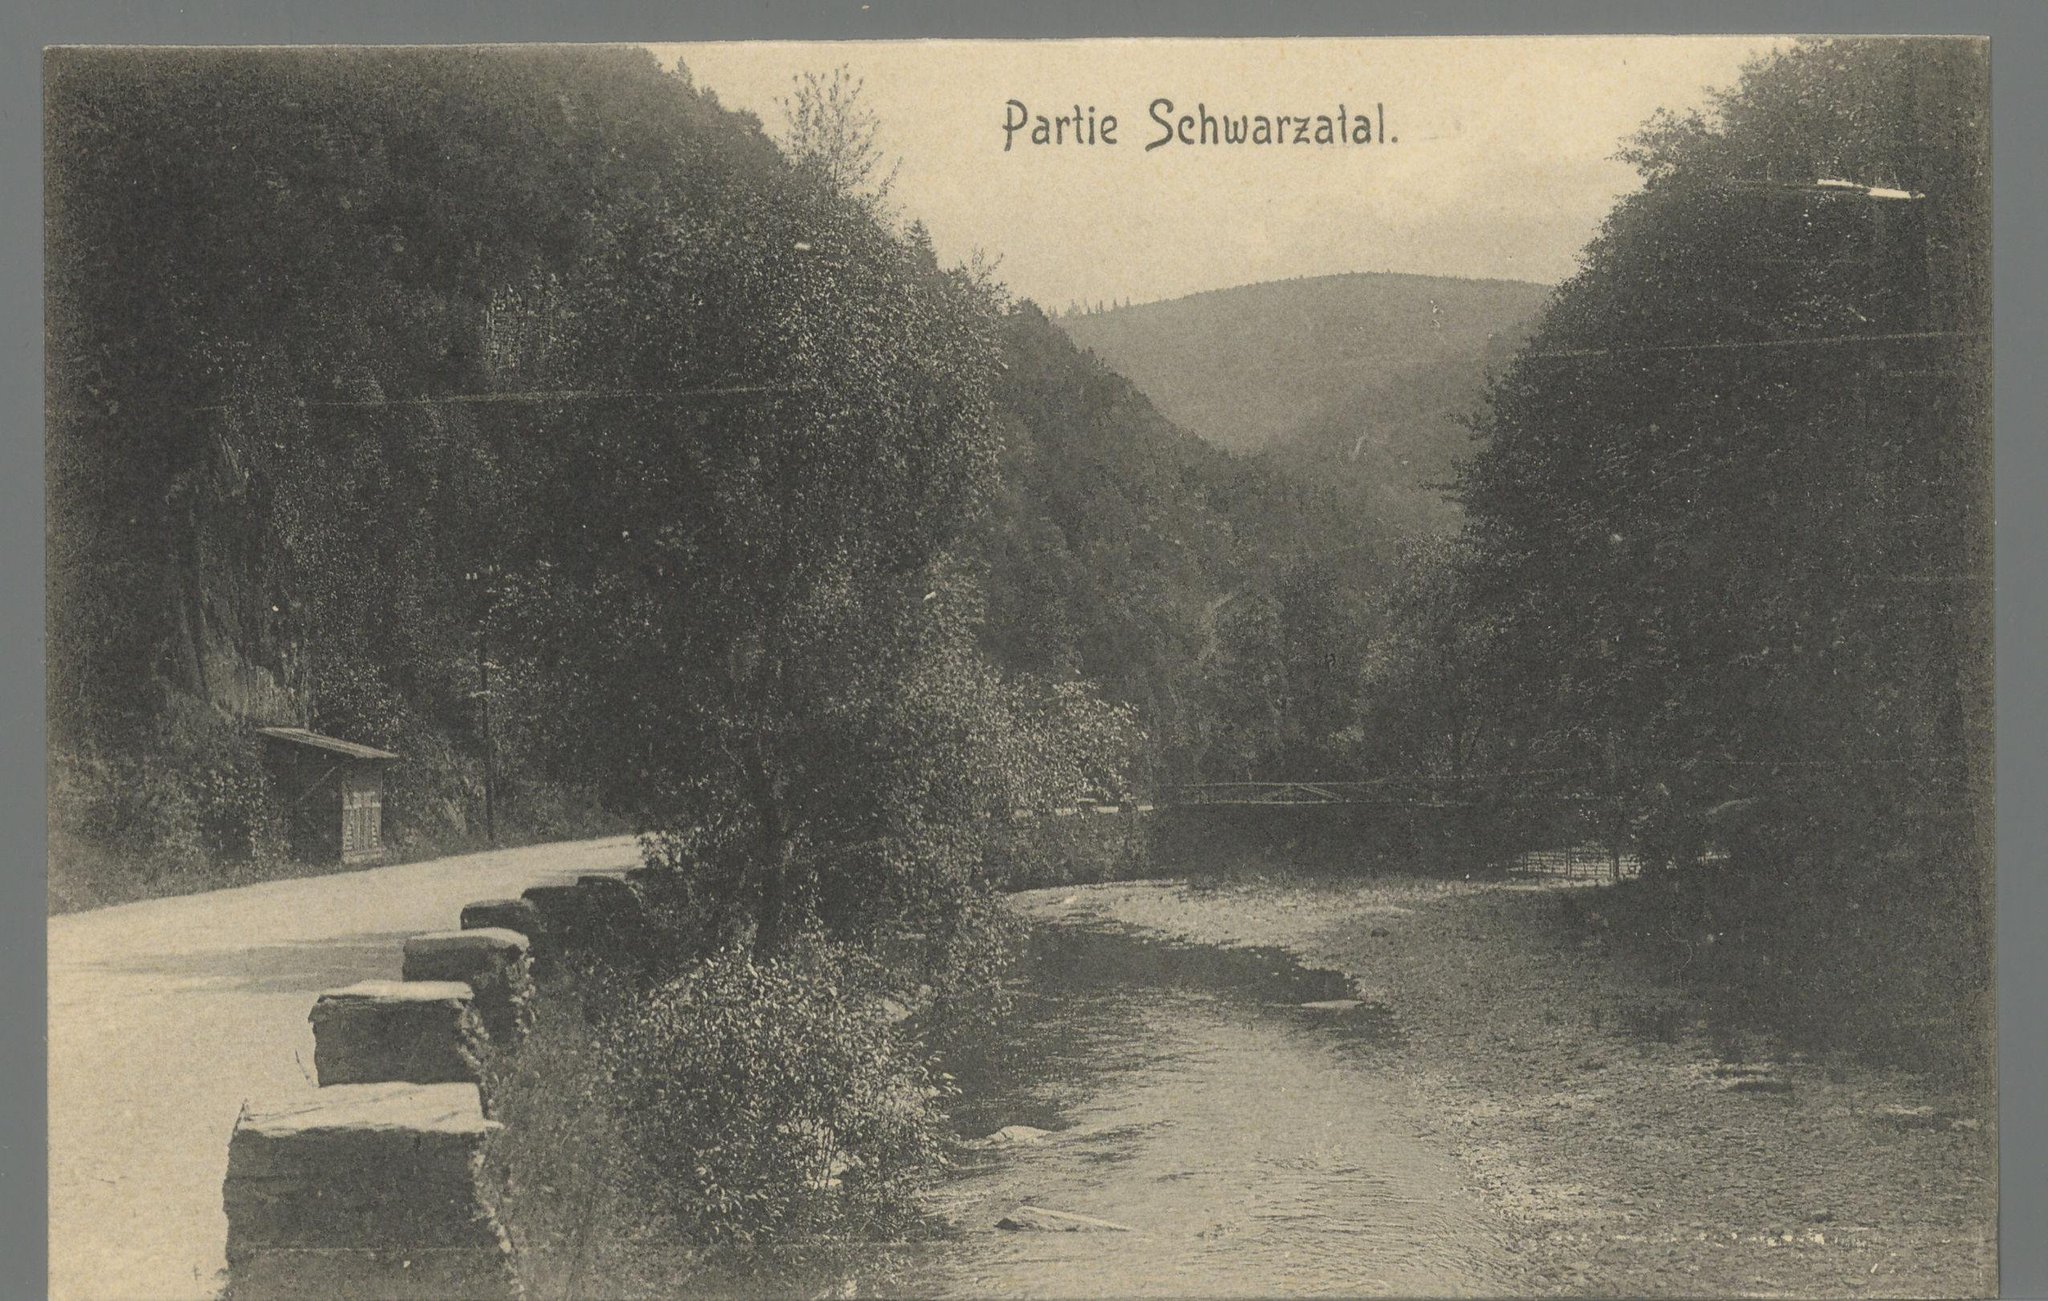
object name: photomechanical print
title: Partie Schwarzatal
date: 1908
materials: cardboard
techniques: photograph, writing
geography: schwarzatal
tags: river, mountains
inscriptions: date